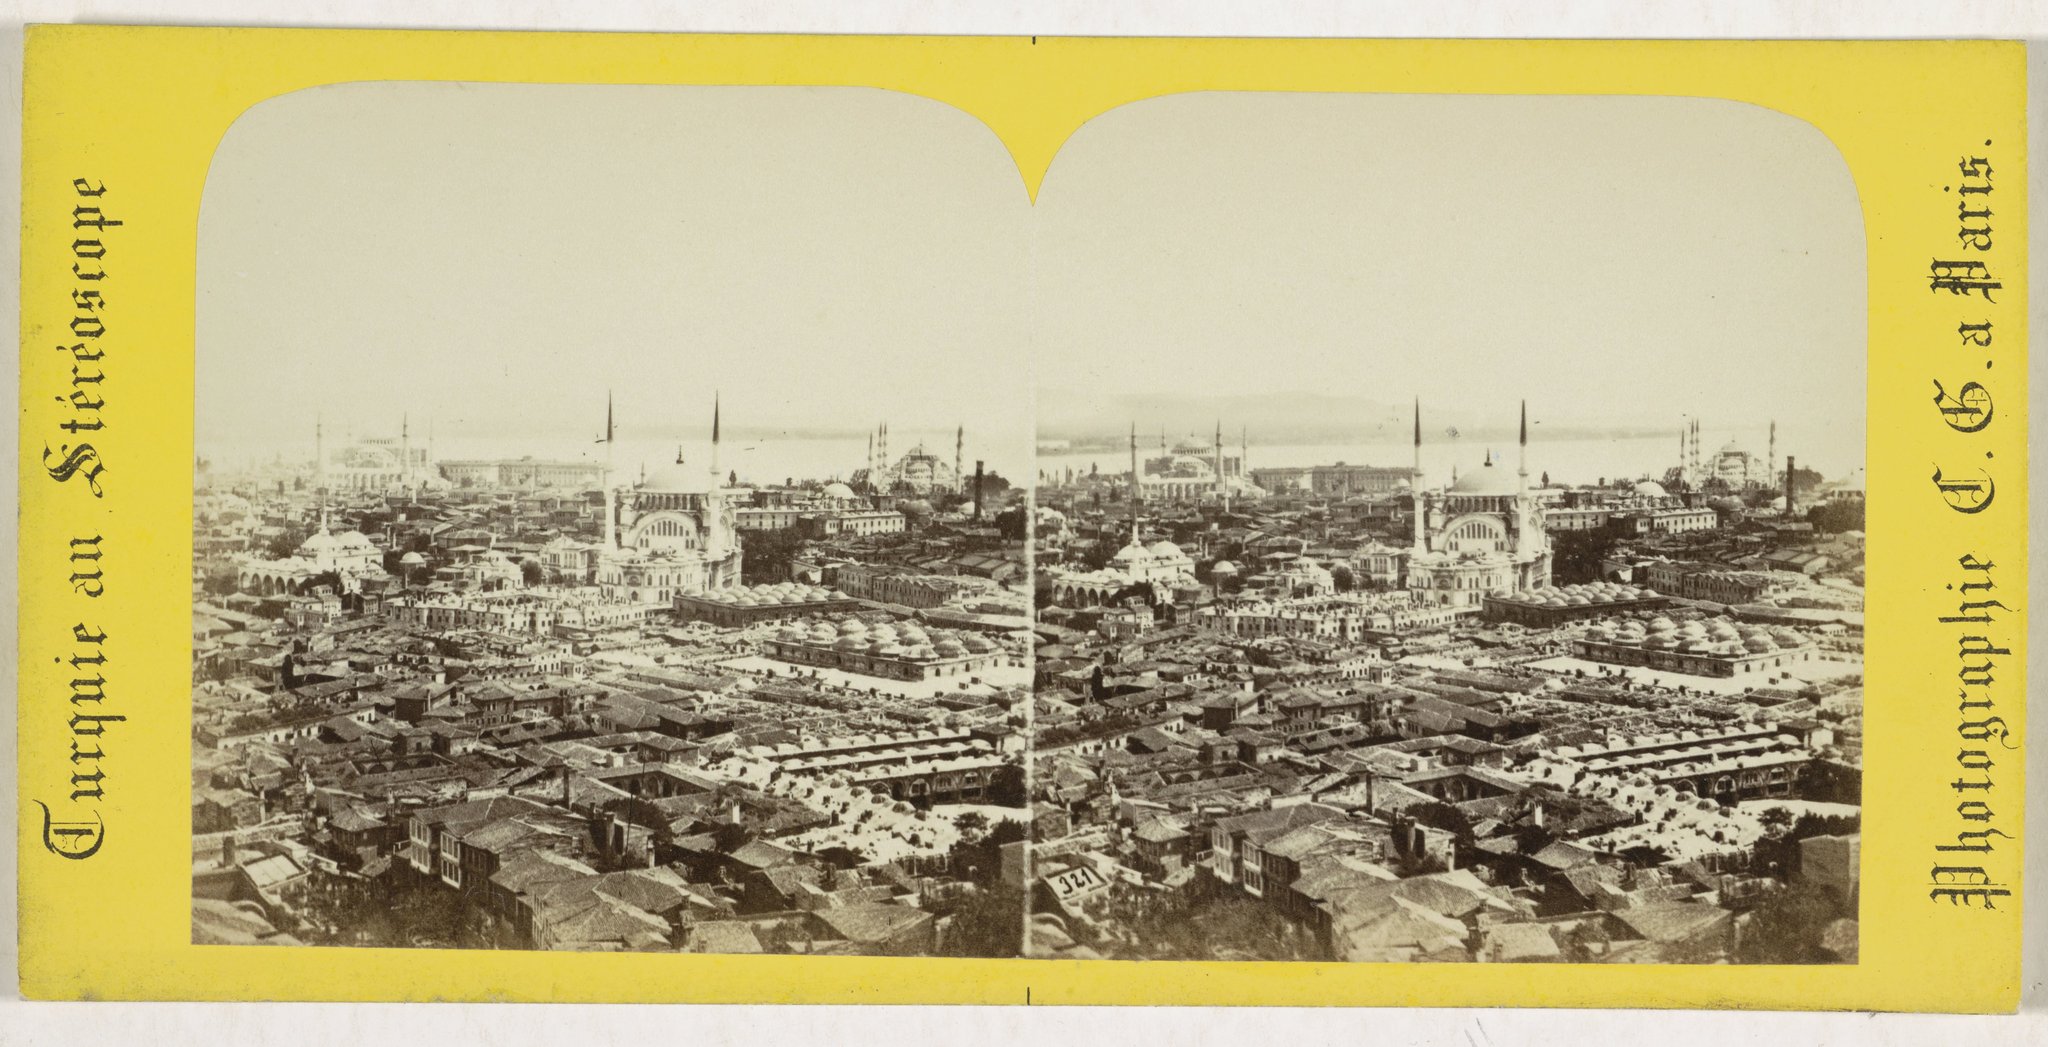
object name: stereograph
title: Turquie au Stéréoscope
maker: charles gaudin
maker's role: publisher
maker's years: 1825-1905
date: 1861-1870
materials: cardboard, paper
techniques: albumen print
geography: istanbul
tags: city-view in general; 'veduta'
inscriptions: number: ‘321’